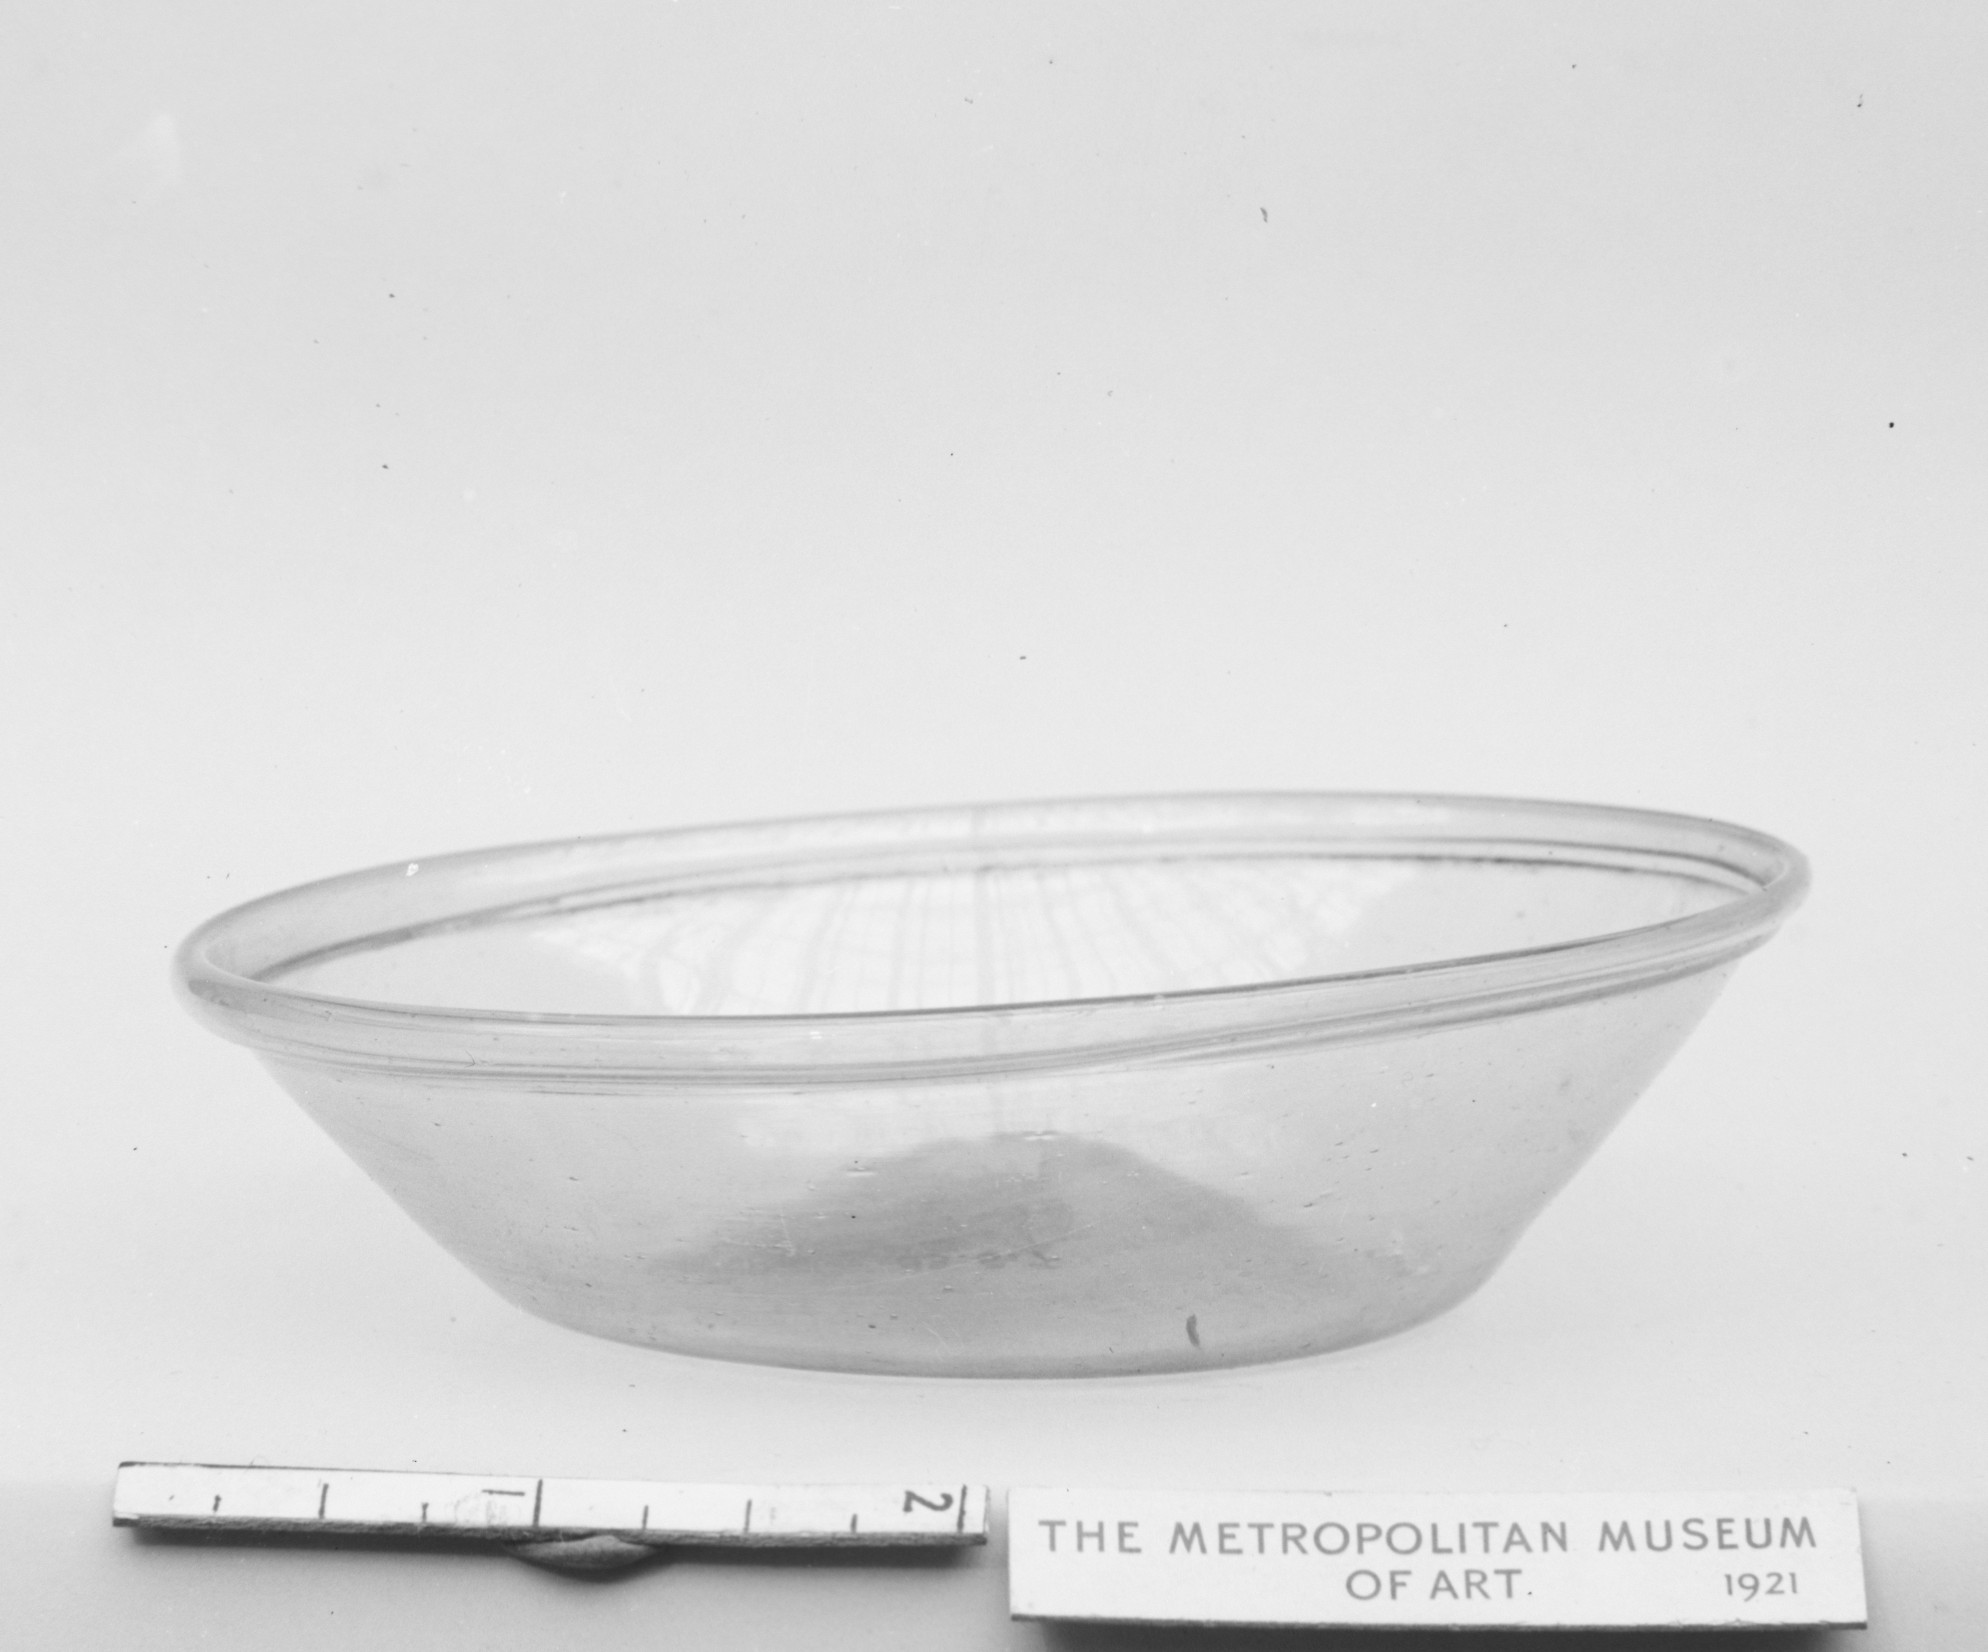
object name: dish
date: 1601-1700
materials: glass